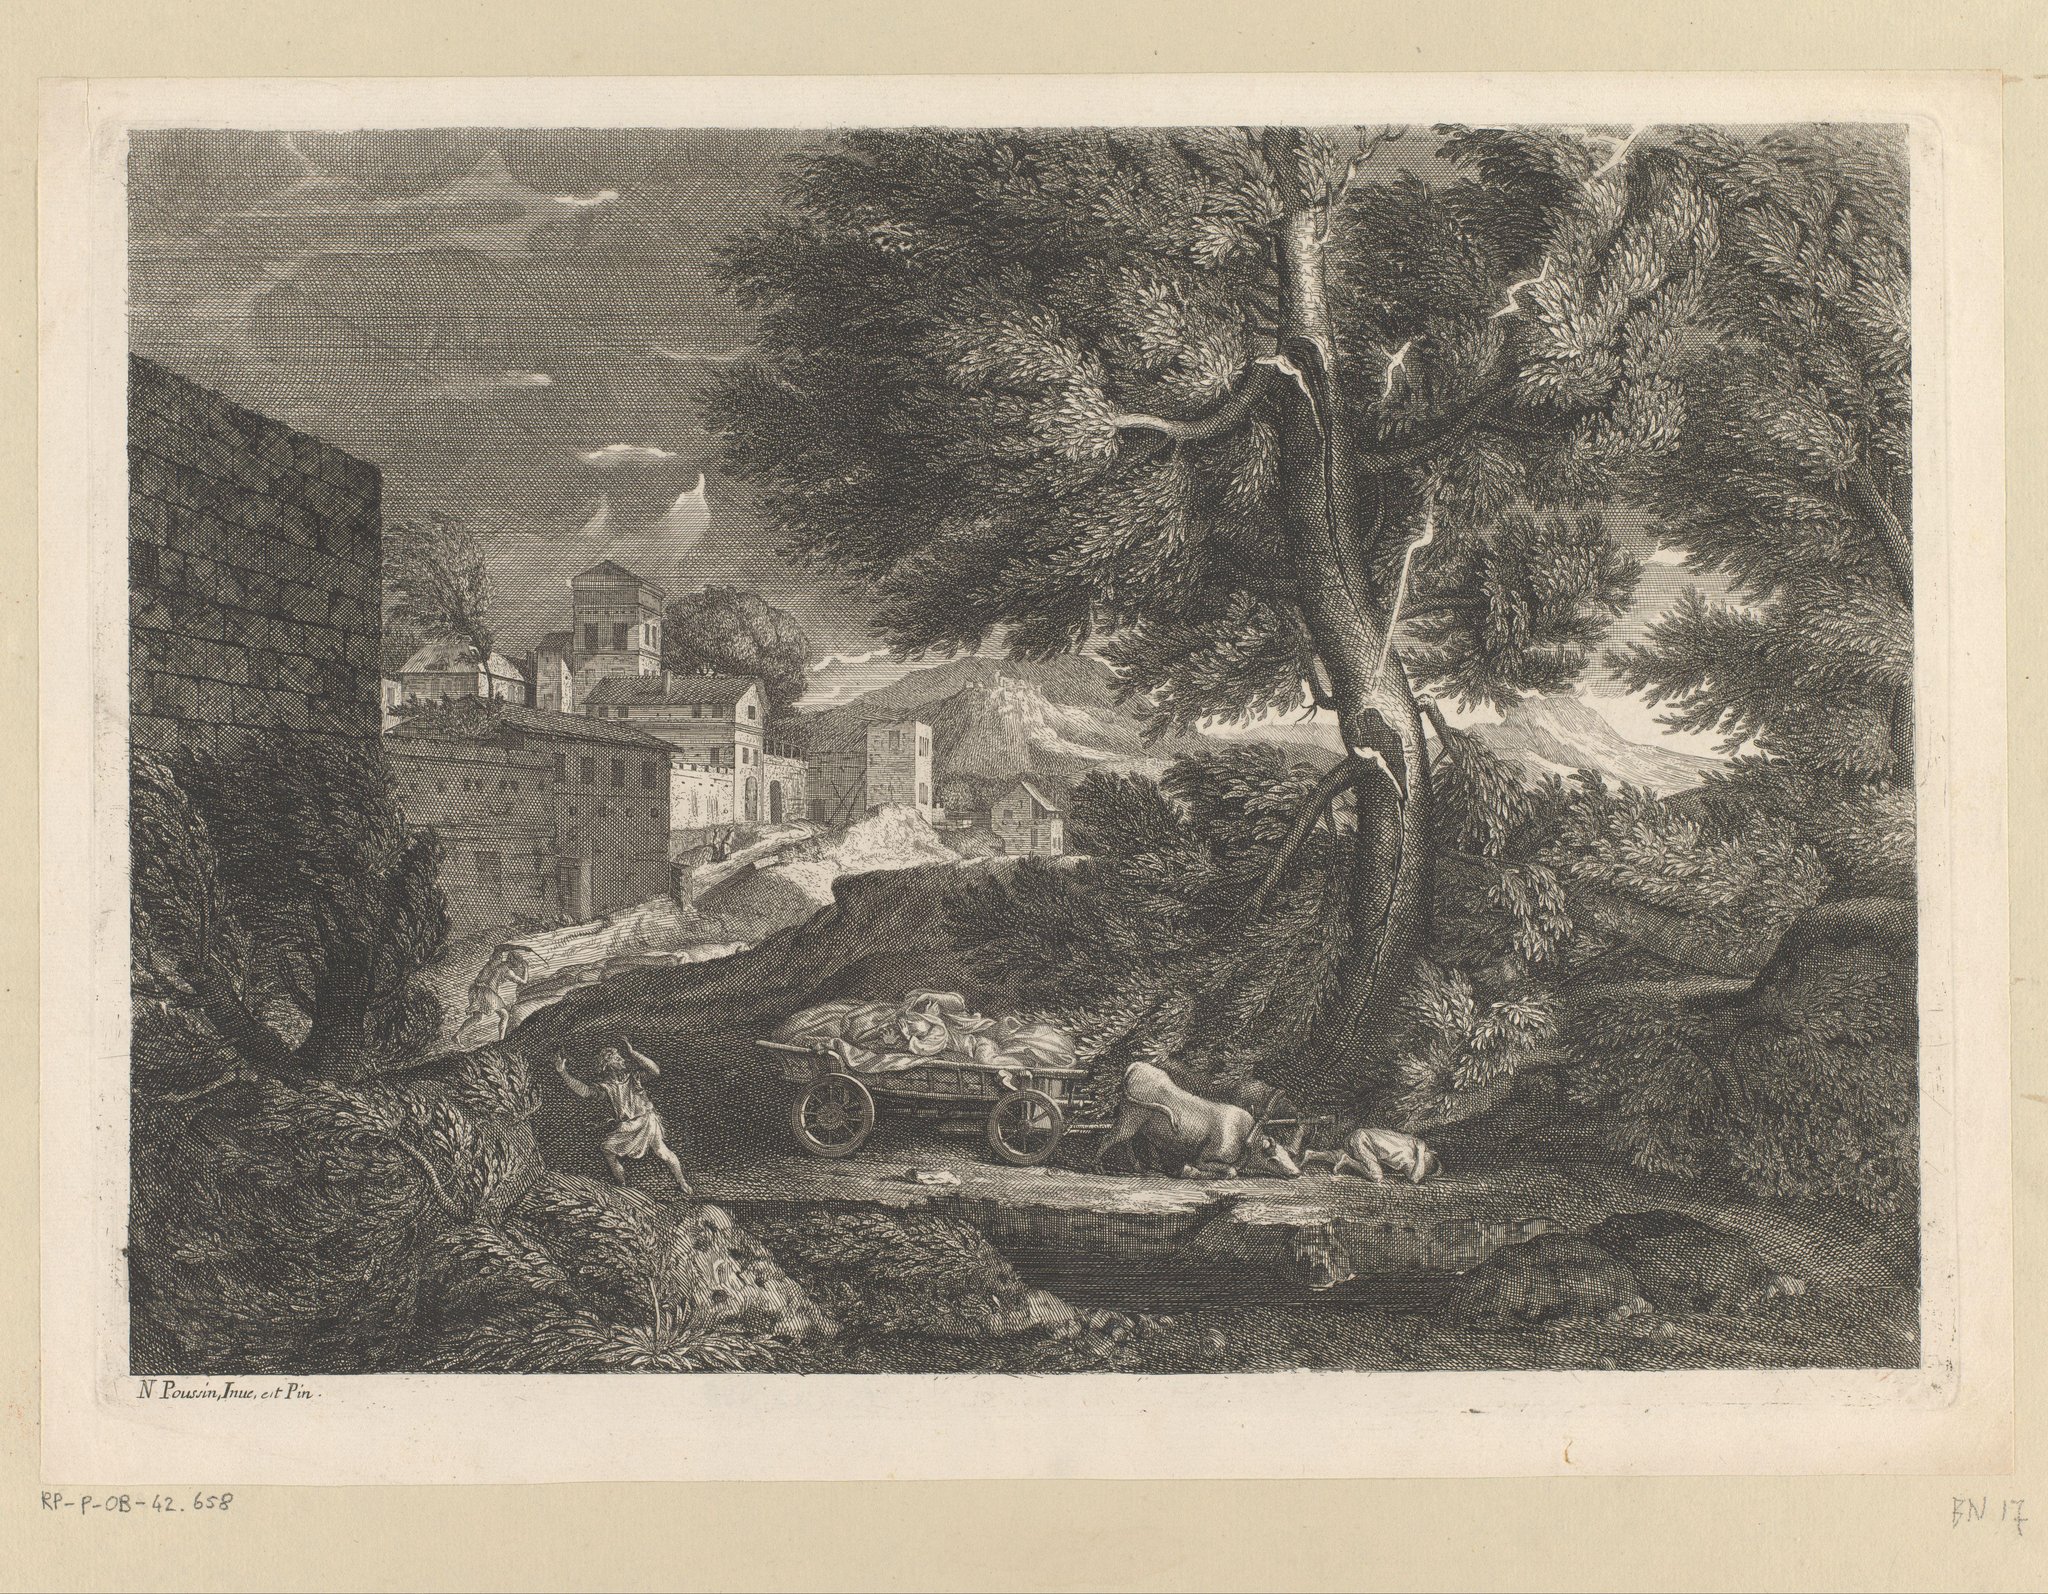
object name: print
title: Suite de six Paysages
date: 1649-1734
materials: paper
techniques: etching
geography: france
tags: landscapes, (farm) wagon, freight wagon, cart (+ accident, collision, crash ~ traffic and transport), lightning, flash of lightning, thunderbolt, accidents with lightning, (farm) wagon, freight wagon, cart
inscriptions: collector's mark: Lugt 240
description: Maakt deel uit van een zesdelige serie met landschappen.